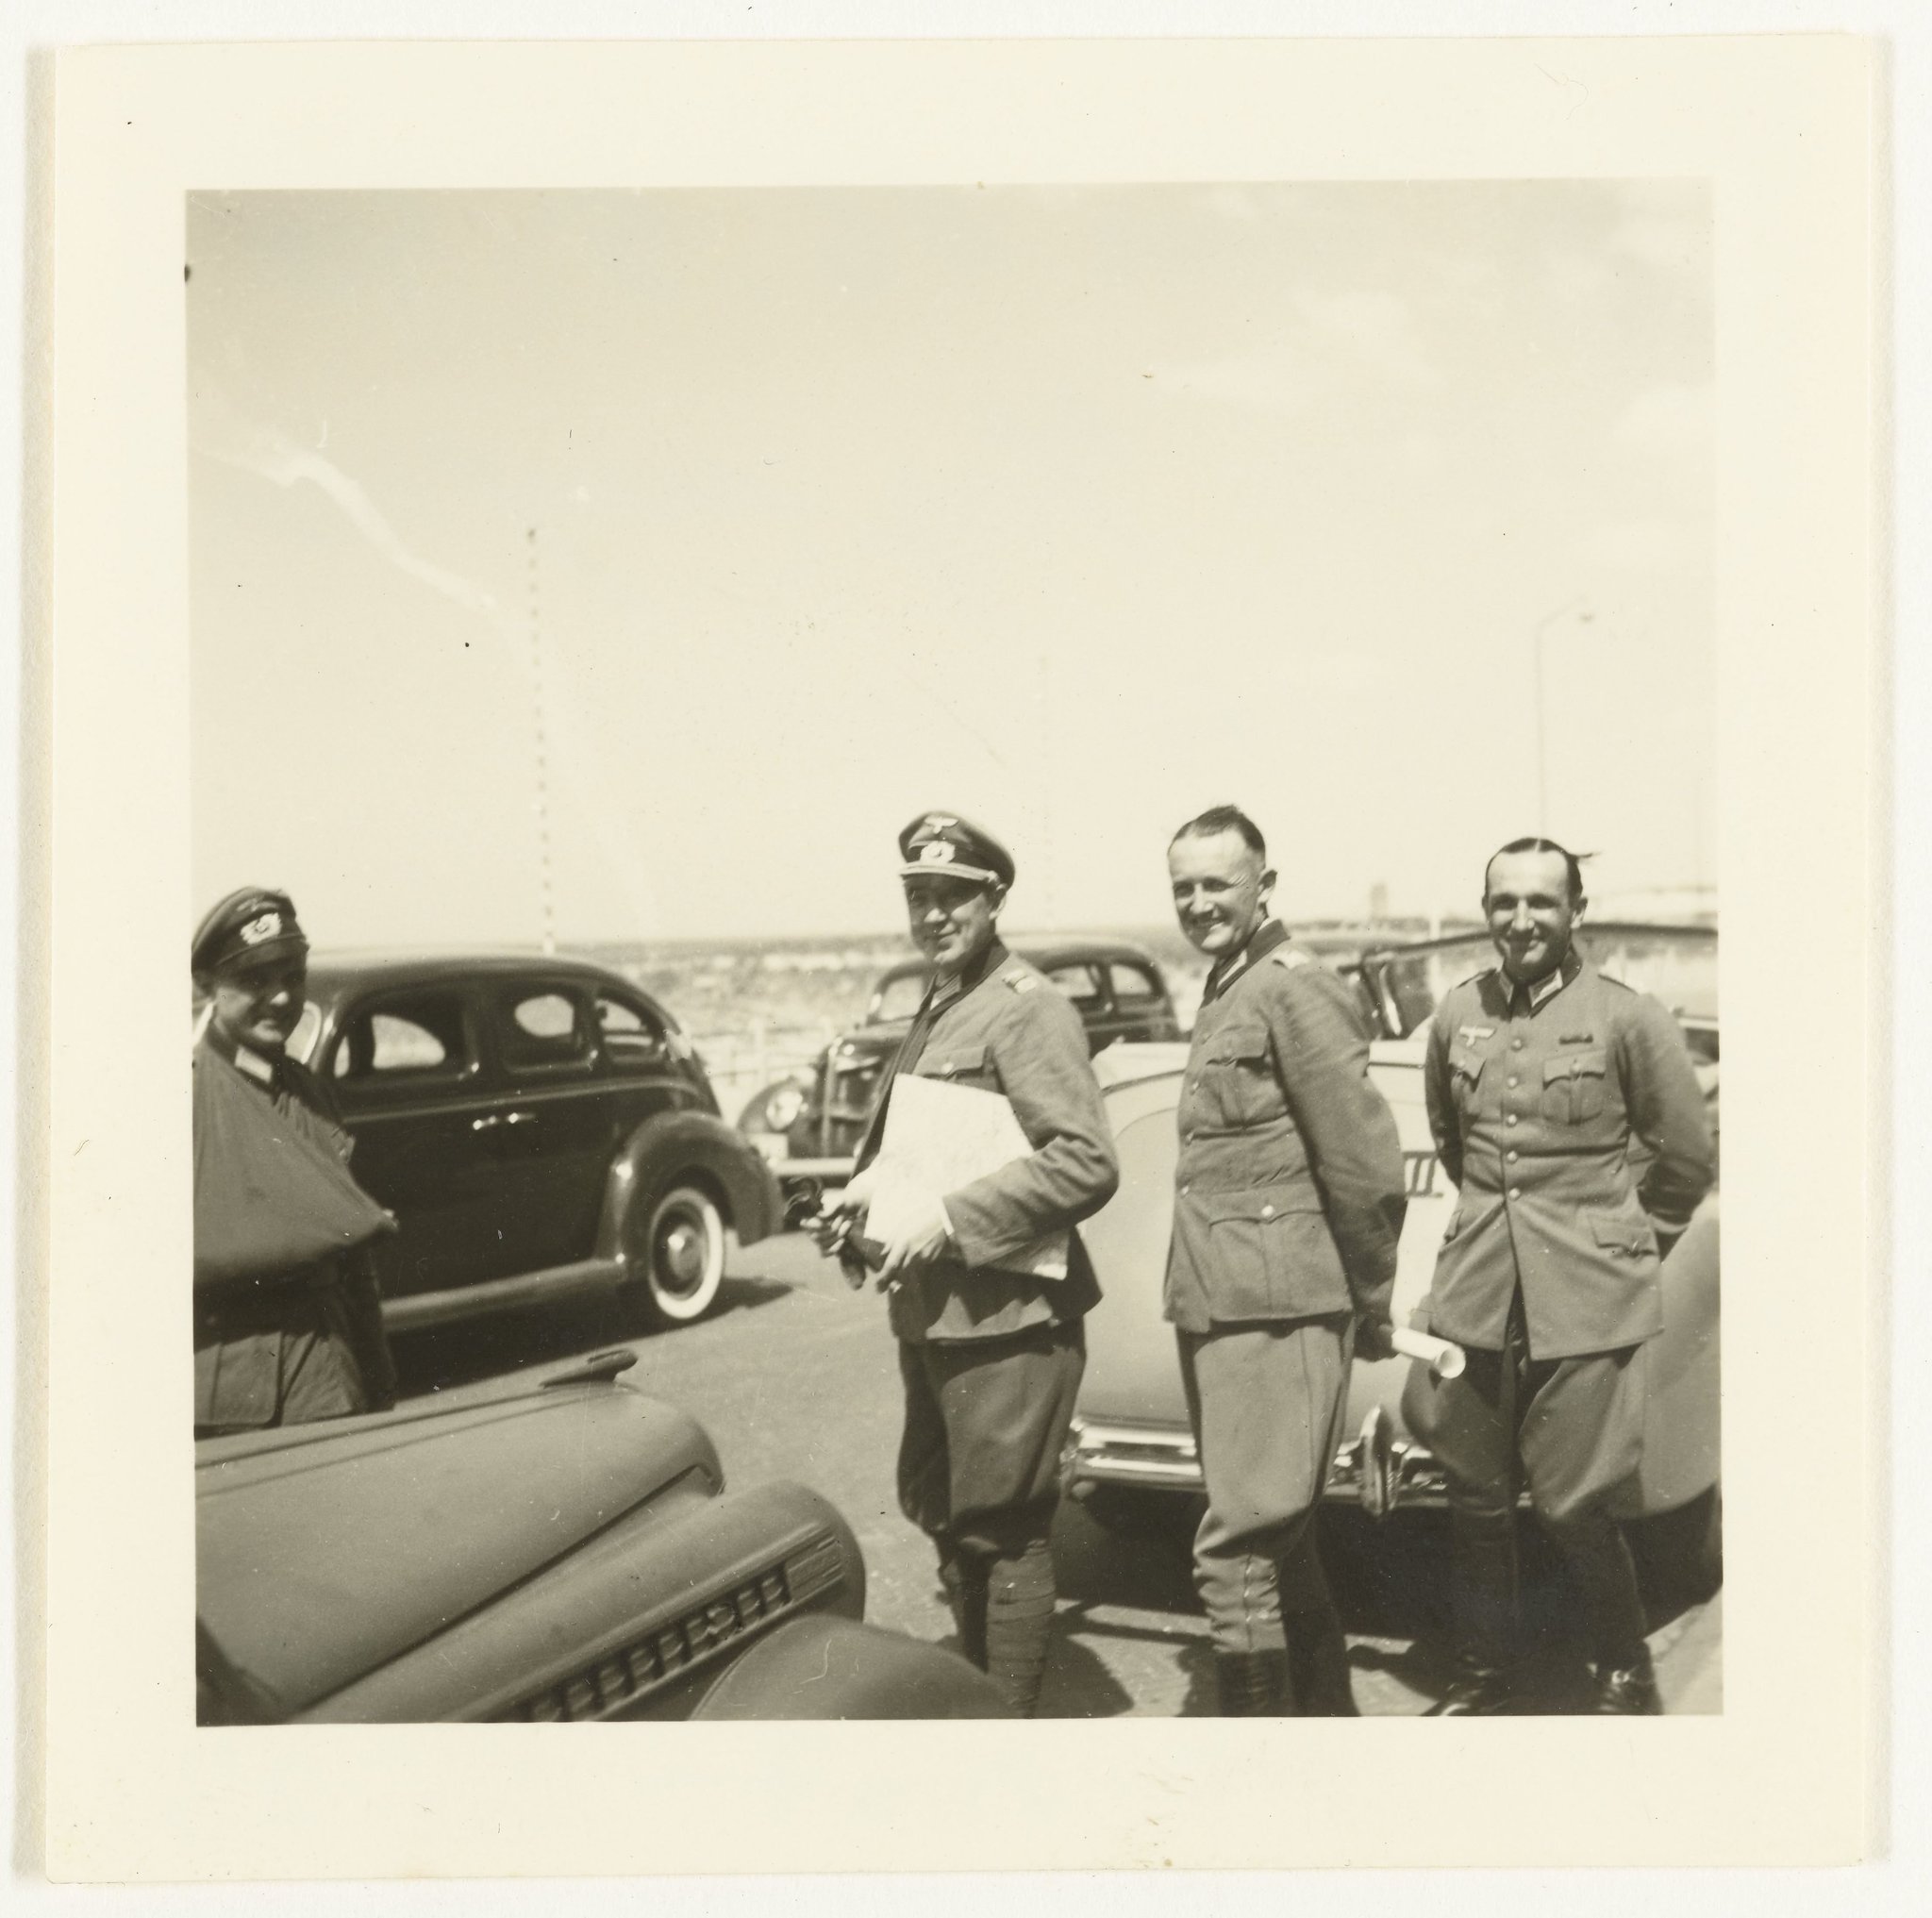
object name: photograph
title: Vier Duitse militairen met auto's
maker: Anonymous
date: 1940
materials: photographic support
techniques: gelatin silver print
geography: katwijk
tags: occupation ~ war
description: Vier Duitse militairen staan bij twee auto's ergens in Katwijk. Rechts de man die ook voorkomt op NG-2007-5-31 en links de militair met de mitella. Achterop een slecht leesbare tekst in het Duits.